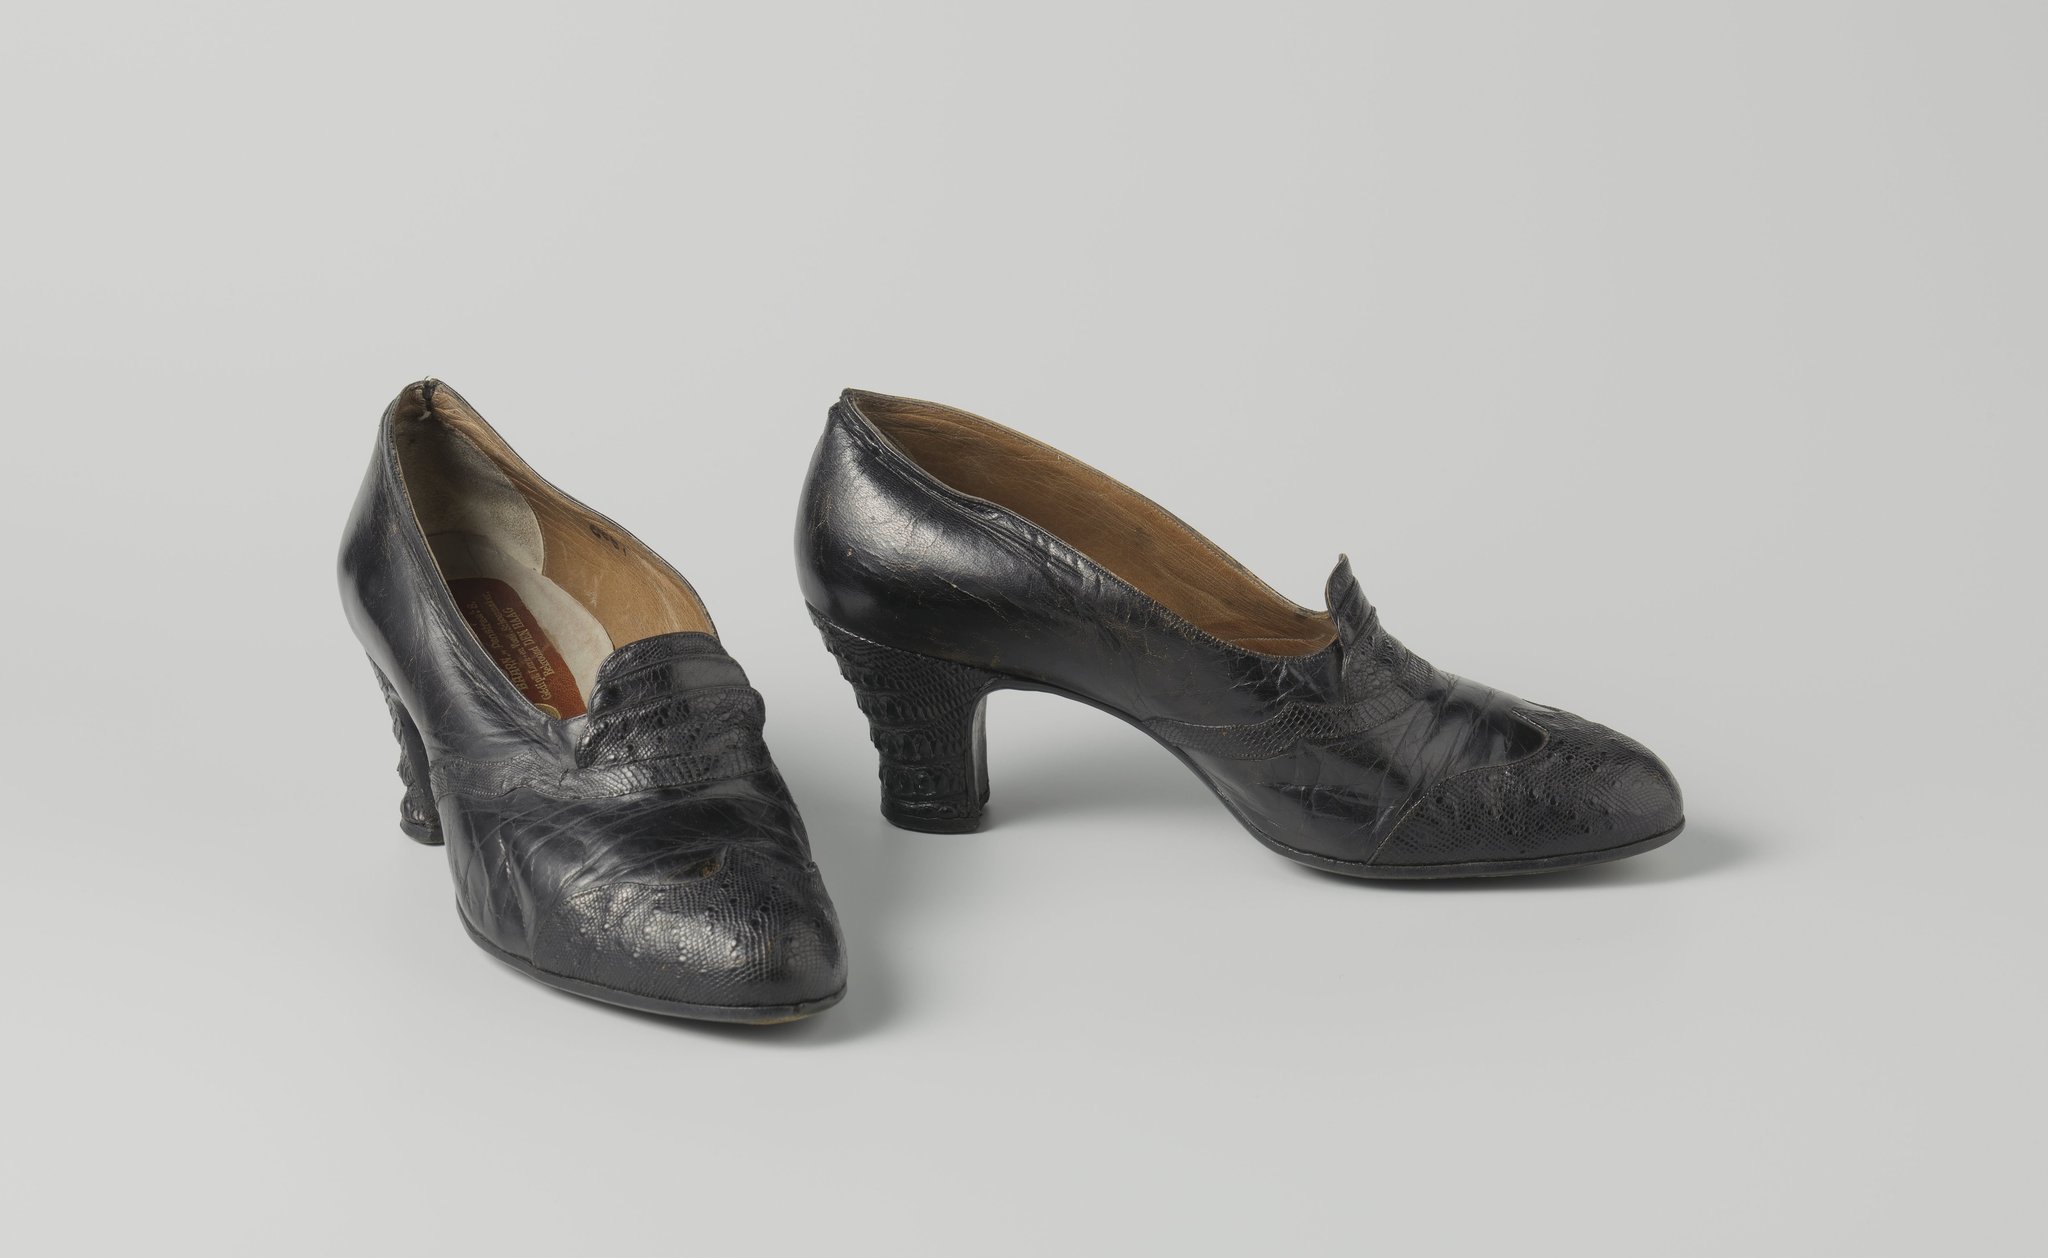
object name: womenswear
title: Damesschoen van zwart leer versierd met zwart reptielleer en opstaande klep op de wreef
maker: h.j. van gaver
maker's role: schoenmaker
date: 1940-1950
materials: leather, metal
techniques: tanning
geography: baarn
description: Damesschoen van zwart leer met opstaande klep op de wreef. Afgeronde neus, blad uit één stuk leer. De voorkant van de hak loopt in een afgeronde hoek recht naar beneden. De zijkant en achterkant van de hak zijn iets getailleerd en bekleed met zwart reptielleer. Leren achterlapje met drie spijkers aan de hak vastgeslagen en leren zool. Blad gevoerd met bruin leer. Hiel gevoerd met geruwd ivoorwit leer. De binnenzool is van grijs leer. Versiering: Op de neus versierd met stuk reptielleer. Langs de schachtrand een golvende rand reptielleer. Op de opstaande klep twee banden reptielleer.